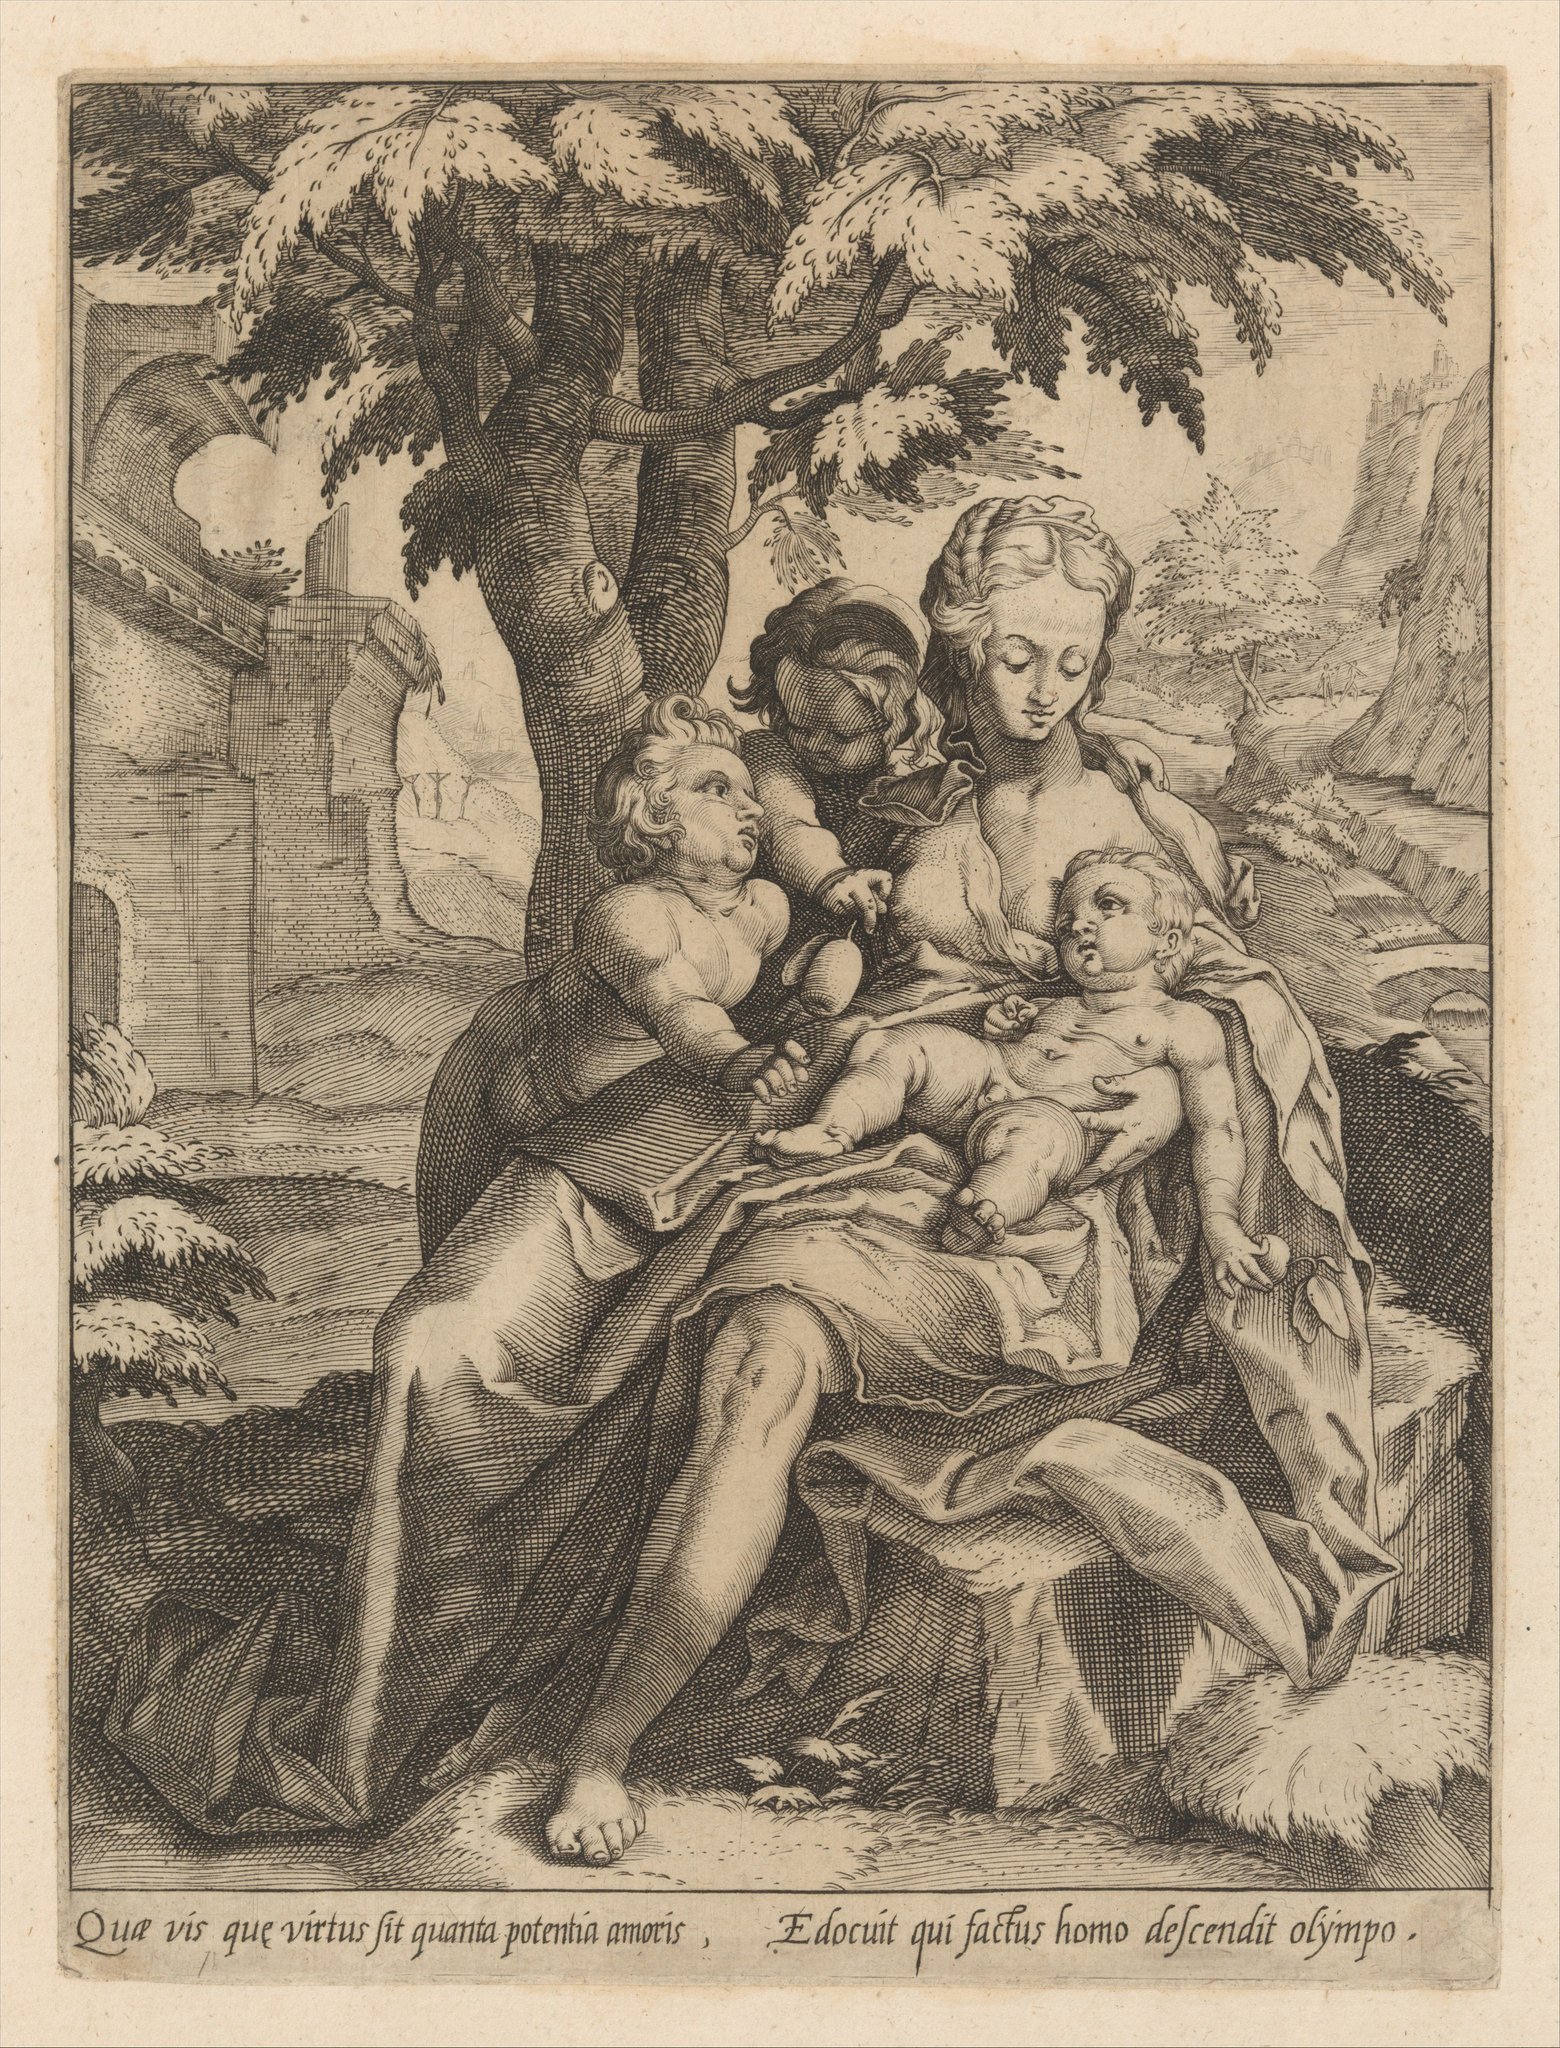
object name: print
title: Charity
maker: goltzius school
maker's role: artist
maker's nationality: netherlandish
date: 1550-1650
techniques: engraving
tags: infants,women,trees